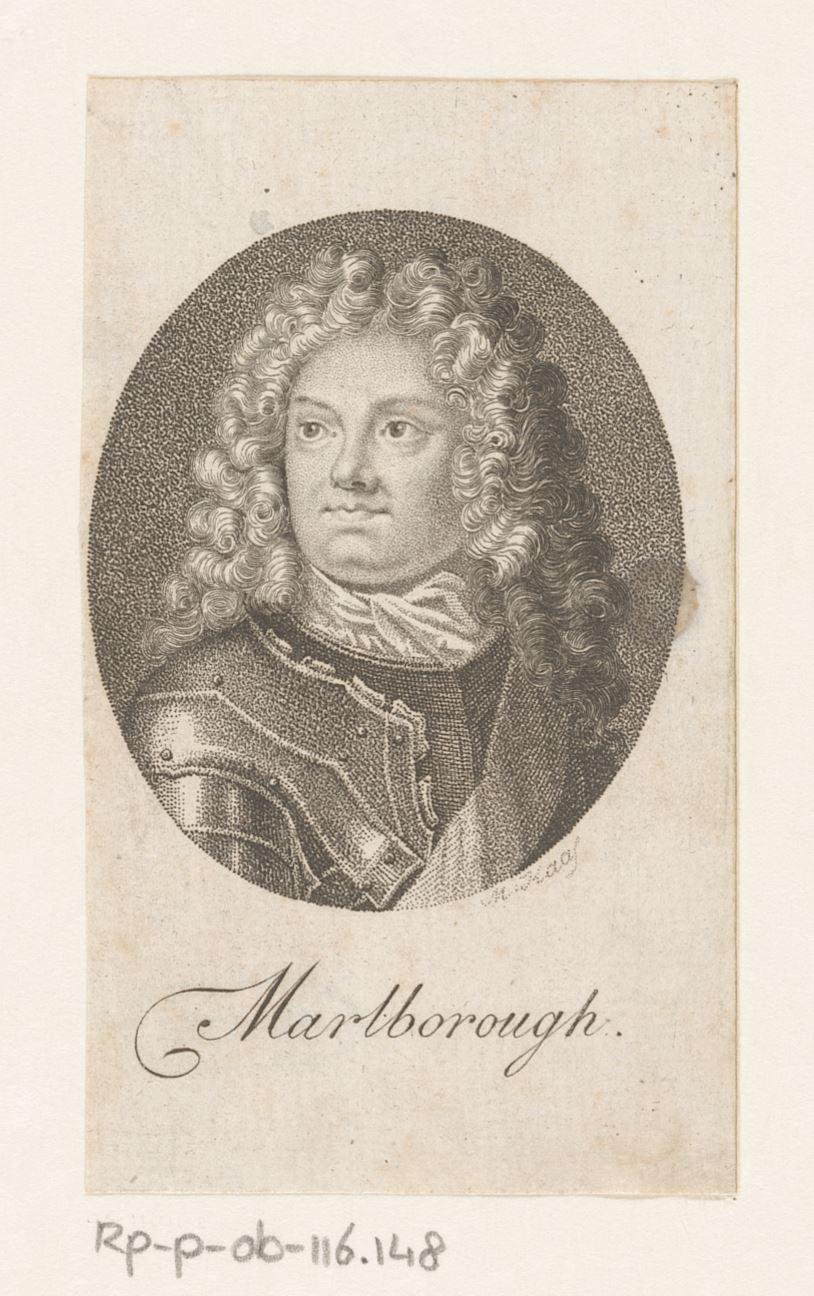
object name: print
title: Portret van John Churchill Marlborough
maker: meno haas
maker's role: print maker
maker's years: 1752-1833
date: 1762-1833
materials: paper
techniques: engraving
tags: john churchill (1e hertog van marlborough), armour, historical persons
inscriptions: collector's mark: Lugt 2228